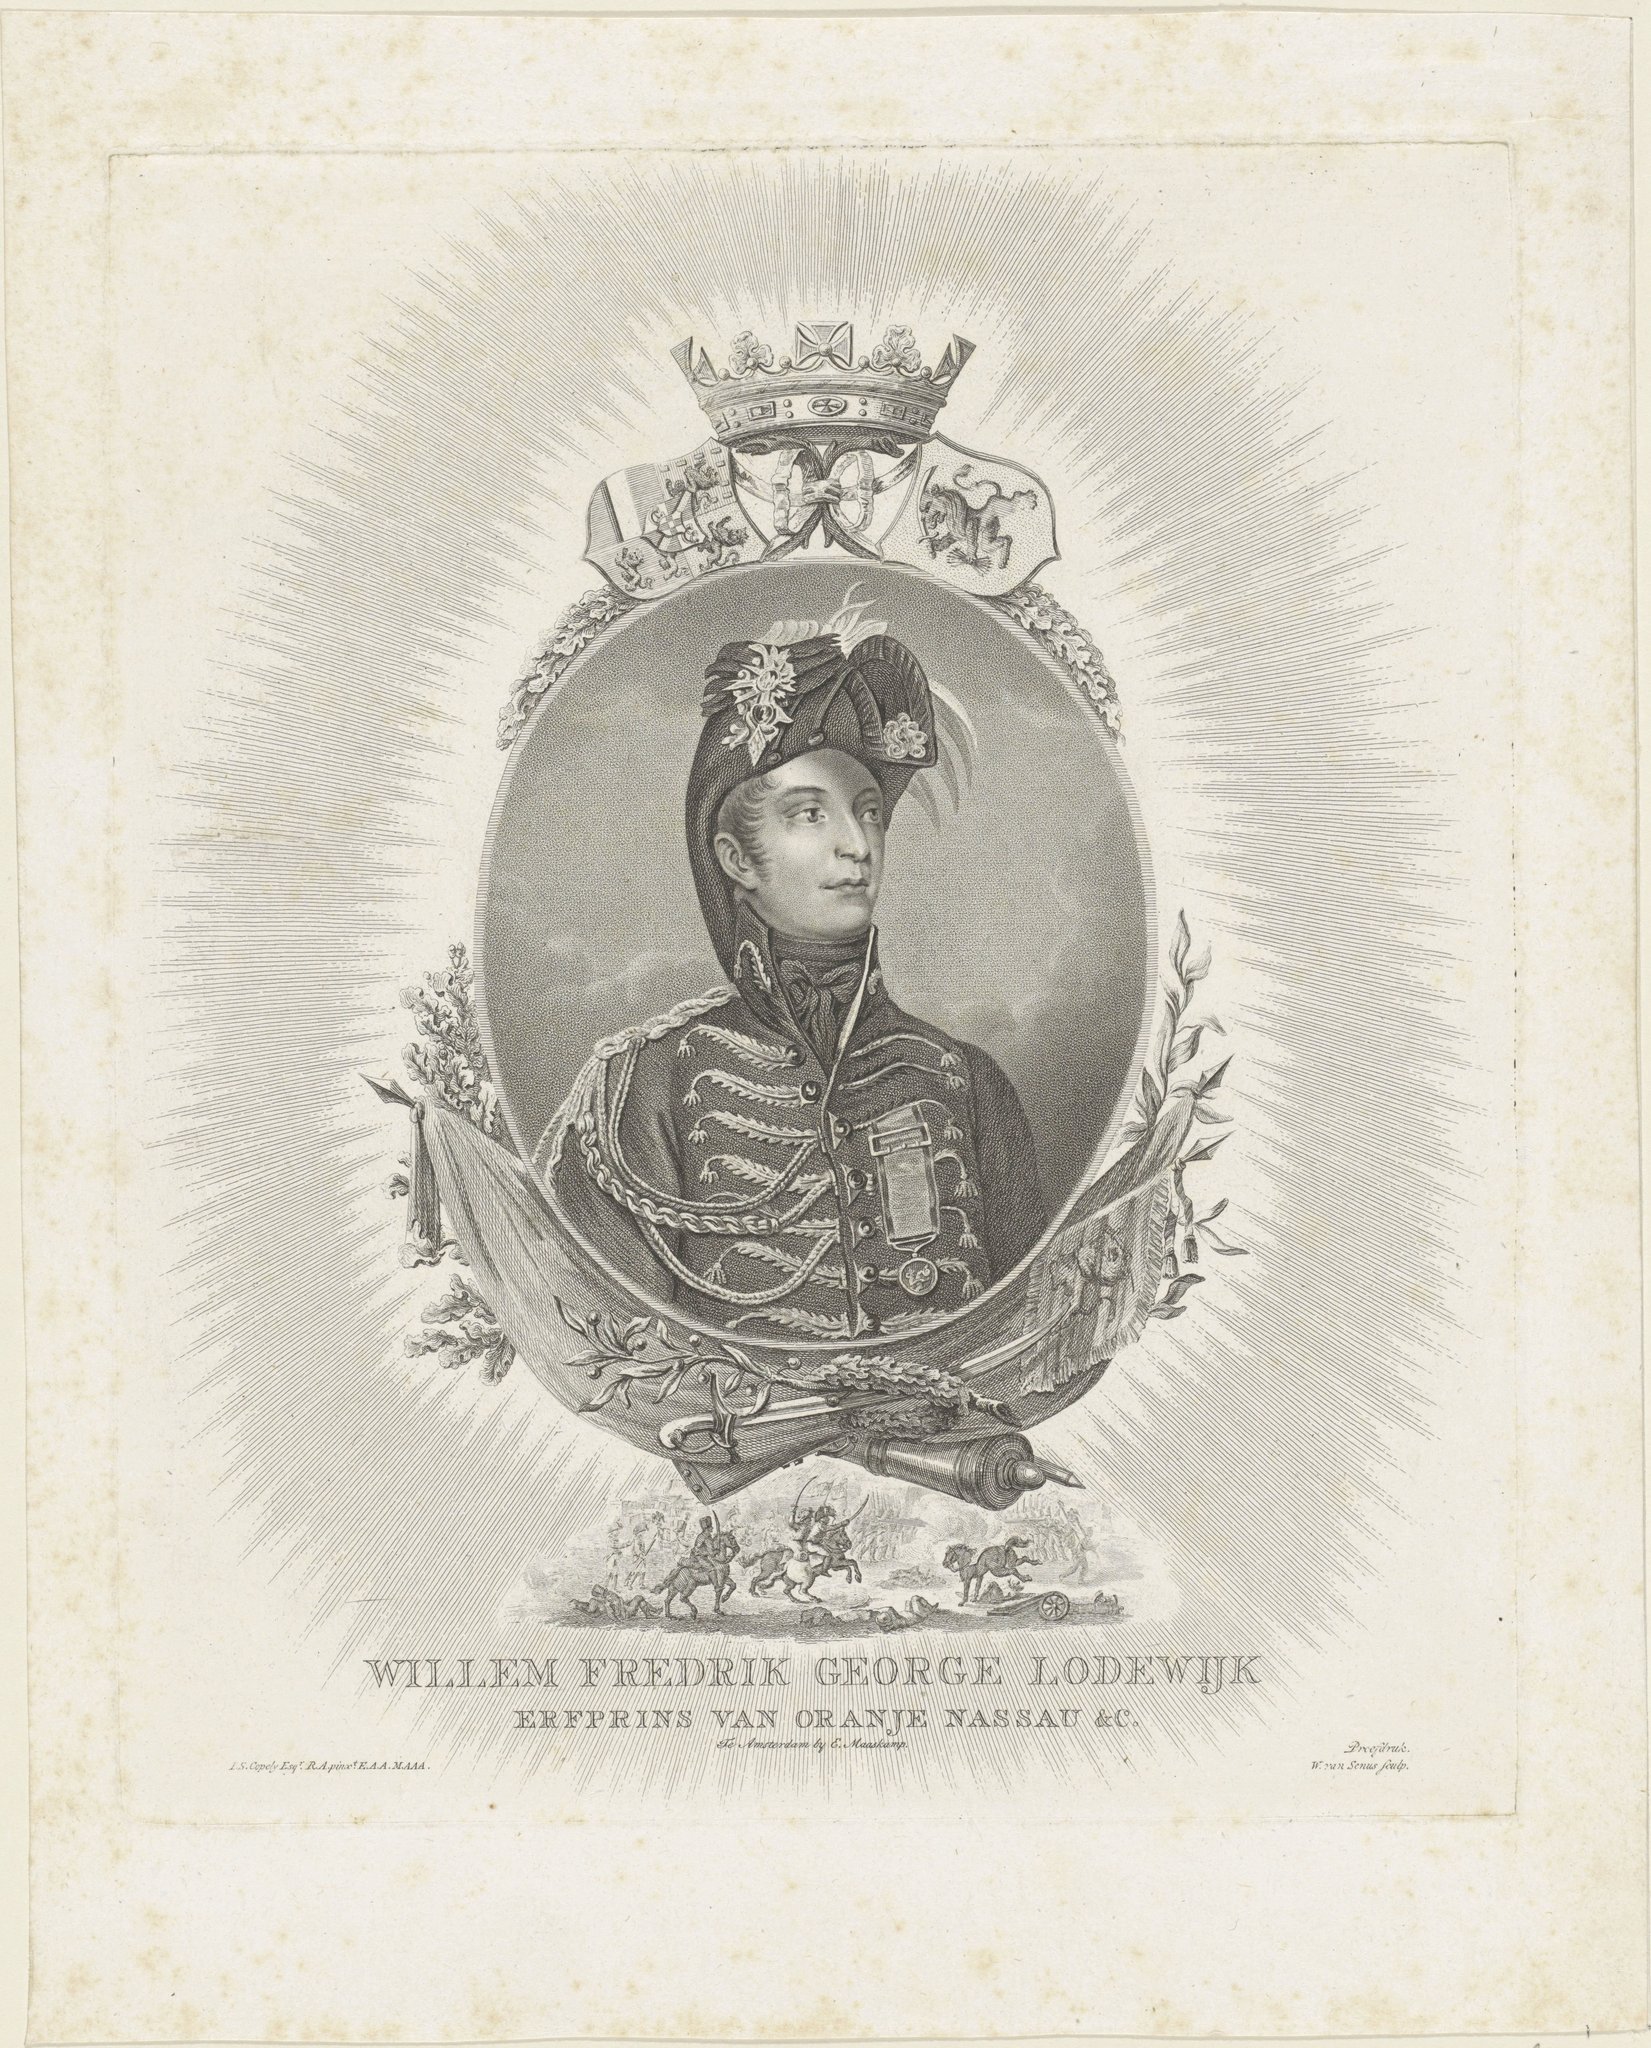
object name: print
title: Portret van Willem II, koning der Nederlanden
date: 1813-1834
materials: paper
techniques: engraving, etching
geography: netherlands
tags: the hague, william ii of the netherlands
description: Portret van Willem II in een ovaal. Daar omheen een aantal allegorische objecten en een stralenkrans. Midden boven twee wapens met een kroon. In de ondermarge een veldslag, zijn naam en zijn titels. Rechtsonder 'Proefdruk.'.